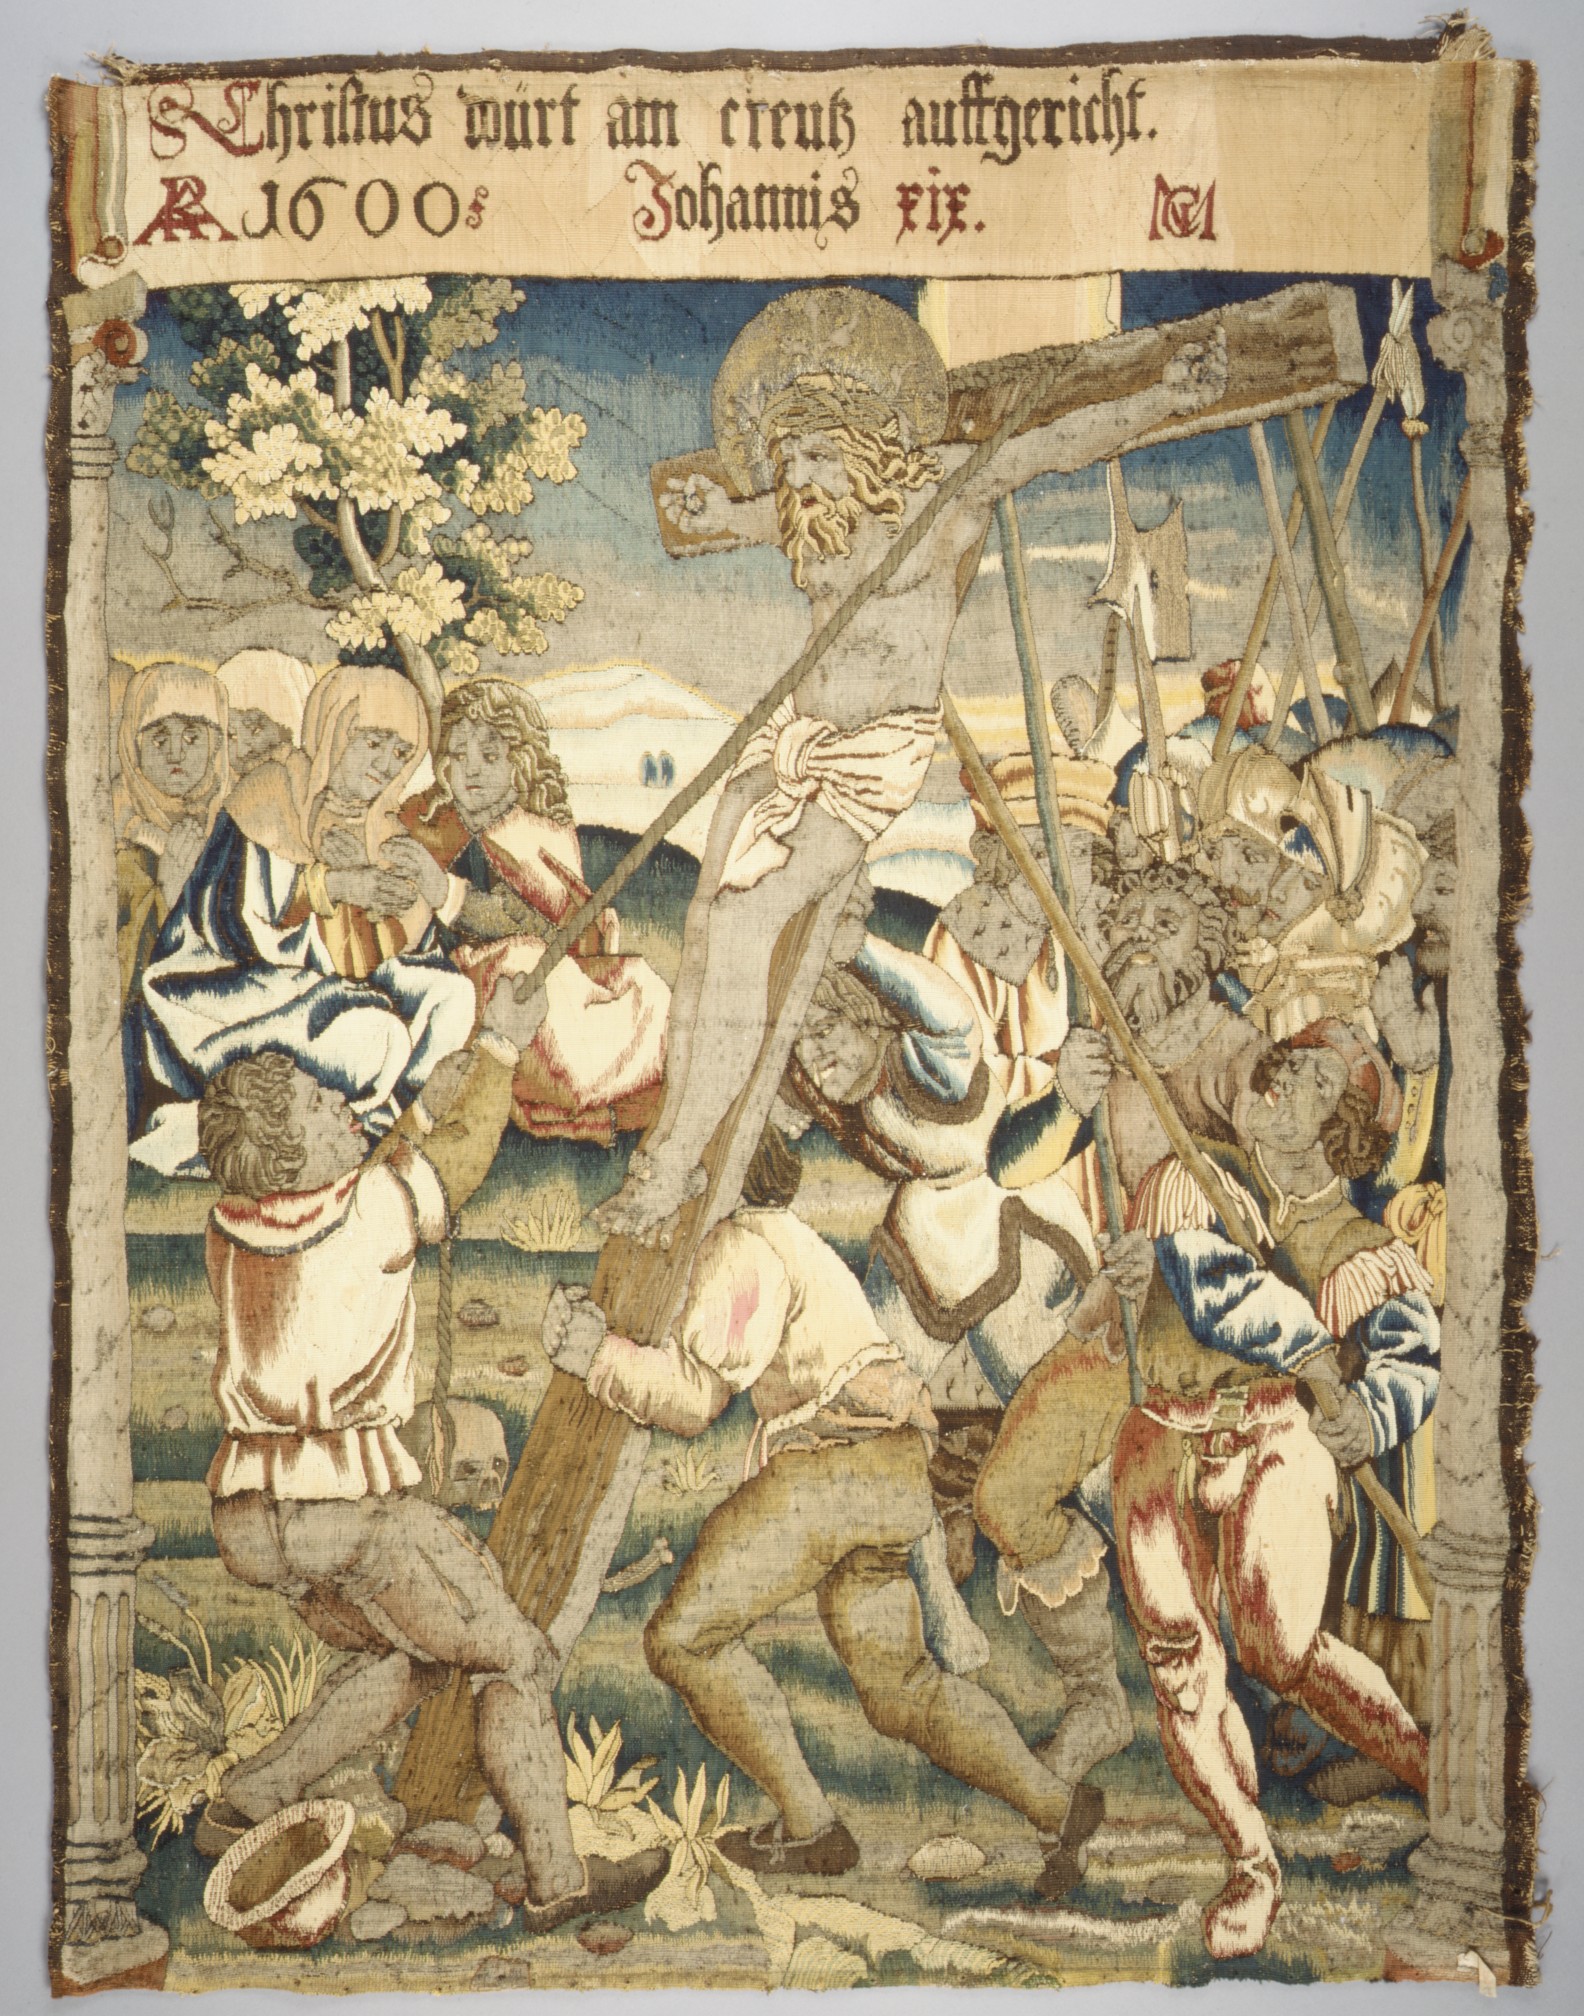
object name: tapestry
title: The Elevation of the Cross from a set of The Passion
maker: hans wechtlin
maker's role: artist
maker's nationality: german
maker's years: 1480-1526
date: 1600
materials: metal thread, silk, wool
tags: men,christ,virgin mary,crucifixion